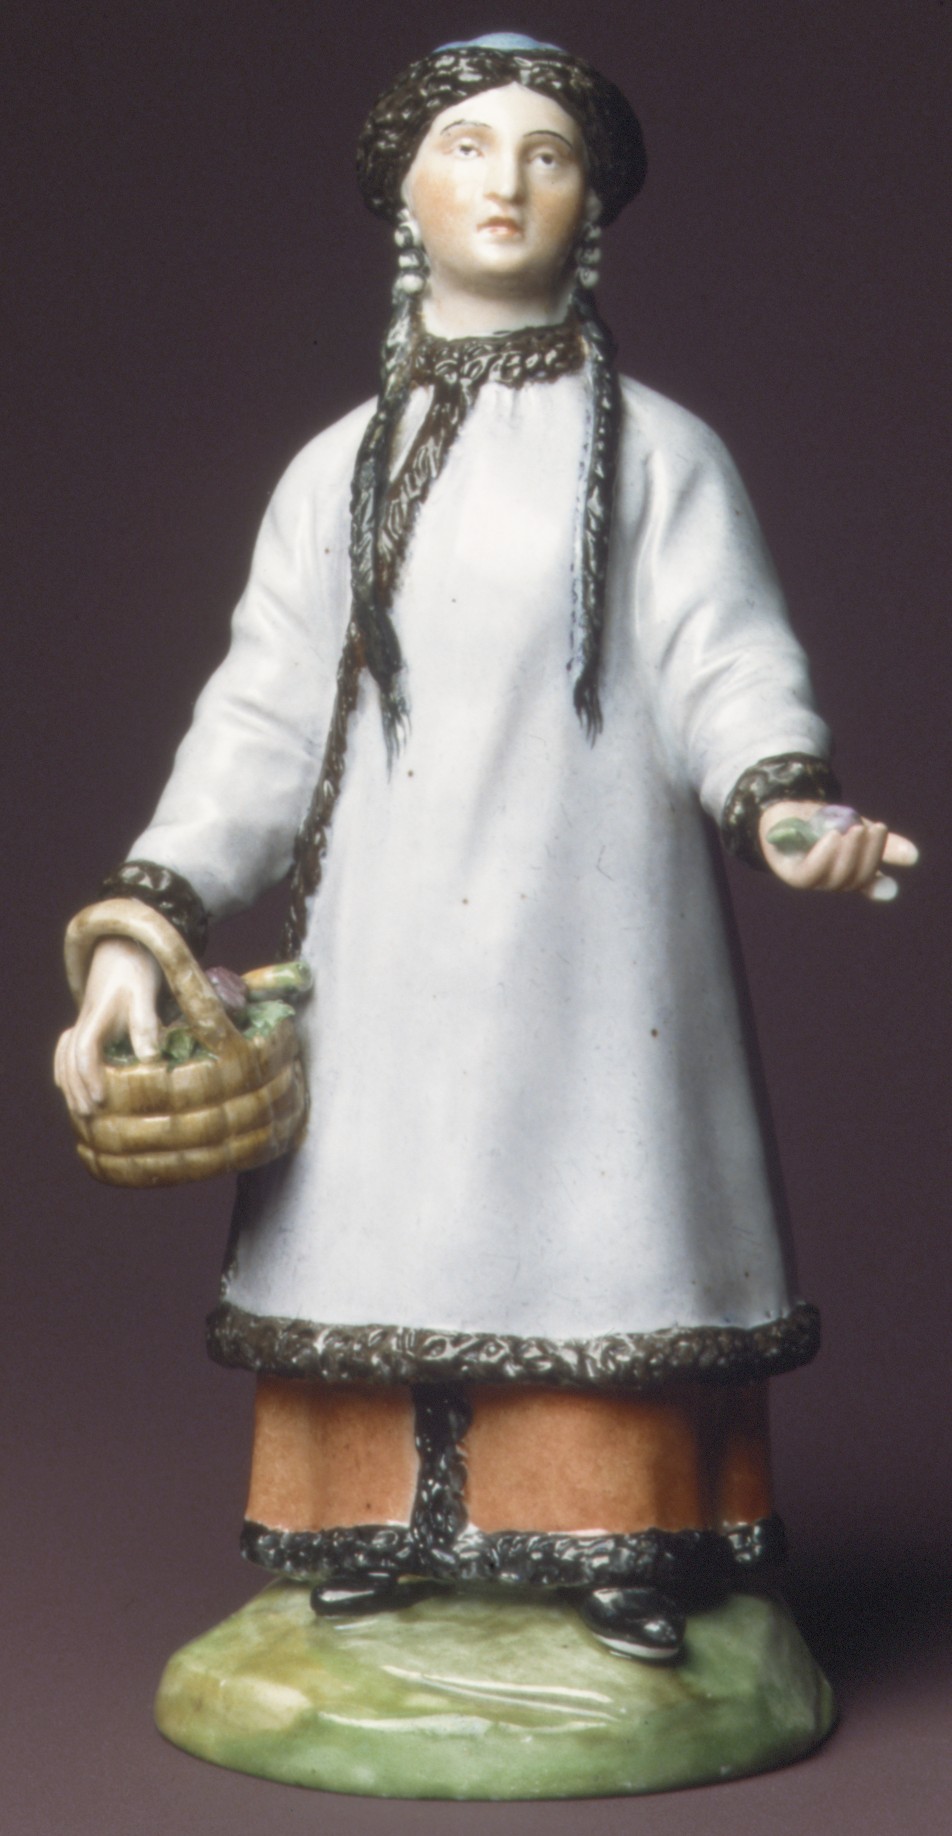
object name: figure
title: Tartar Woman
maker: imperial porcelain manufactory, st. petersburg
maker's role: manufactory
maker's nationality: russian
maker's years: 1744-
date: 1780-1800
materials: hard paste porcelain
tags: women